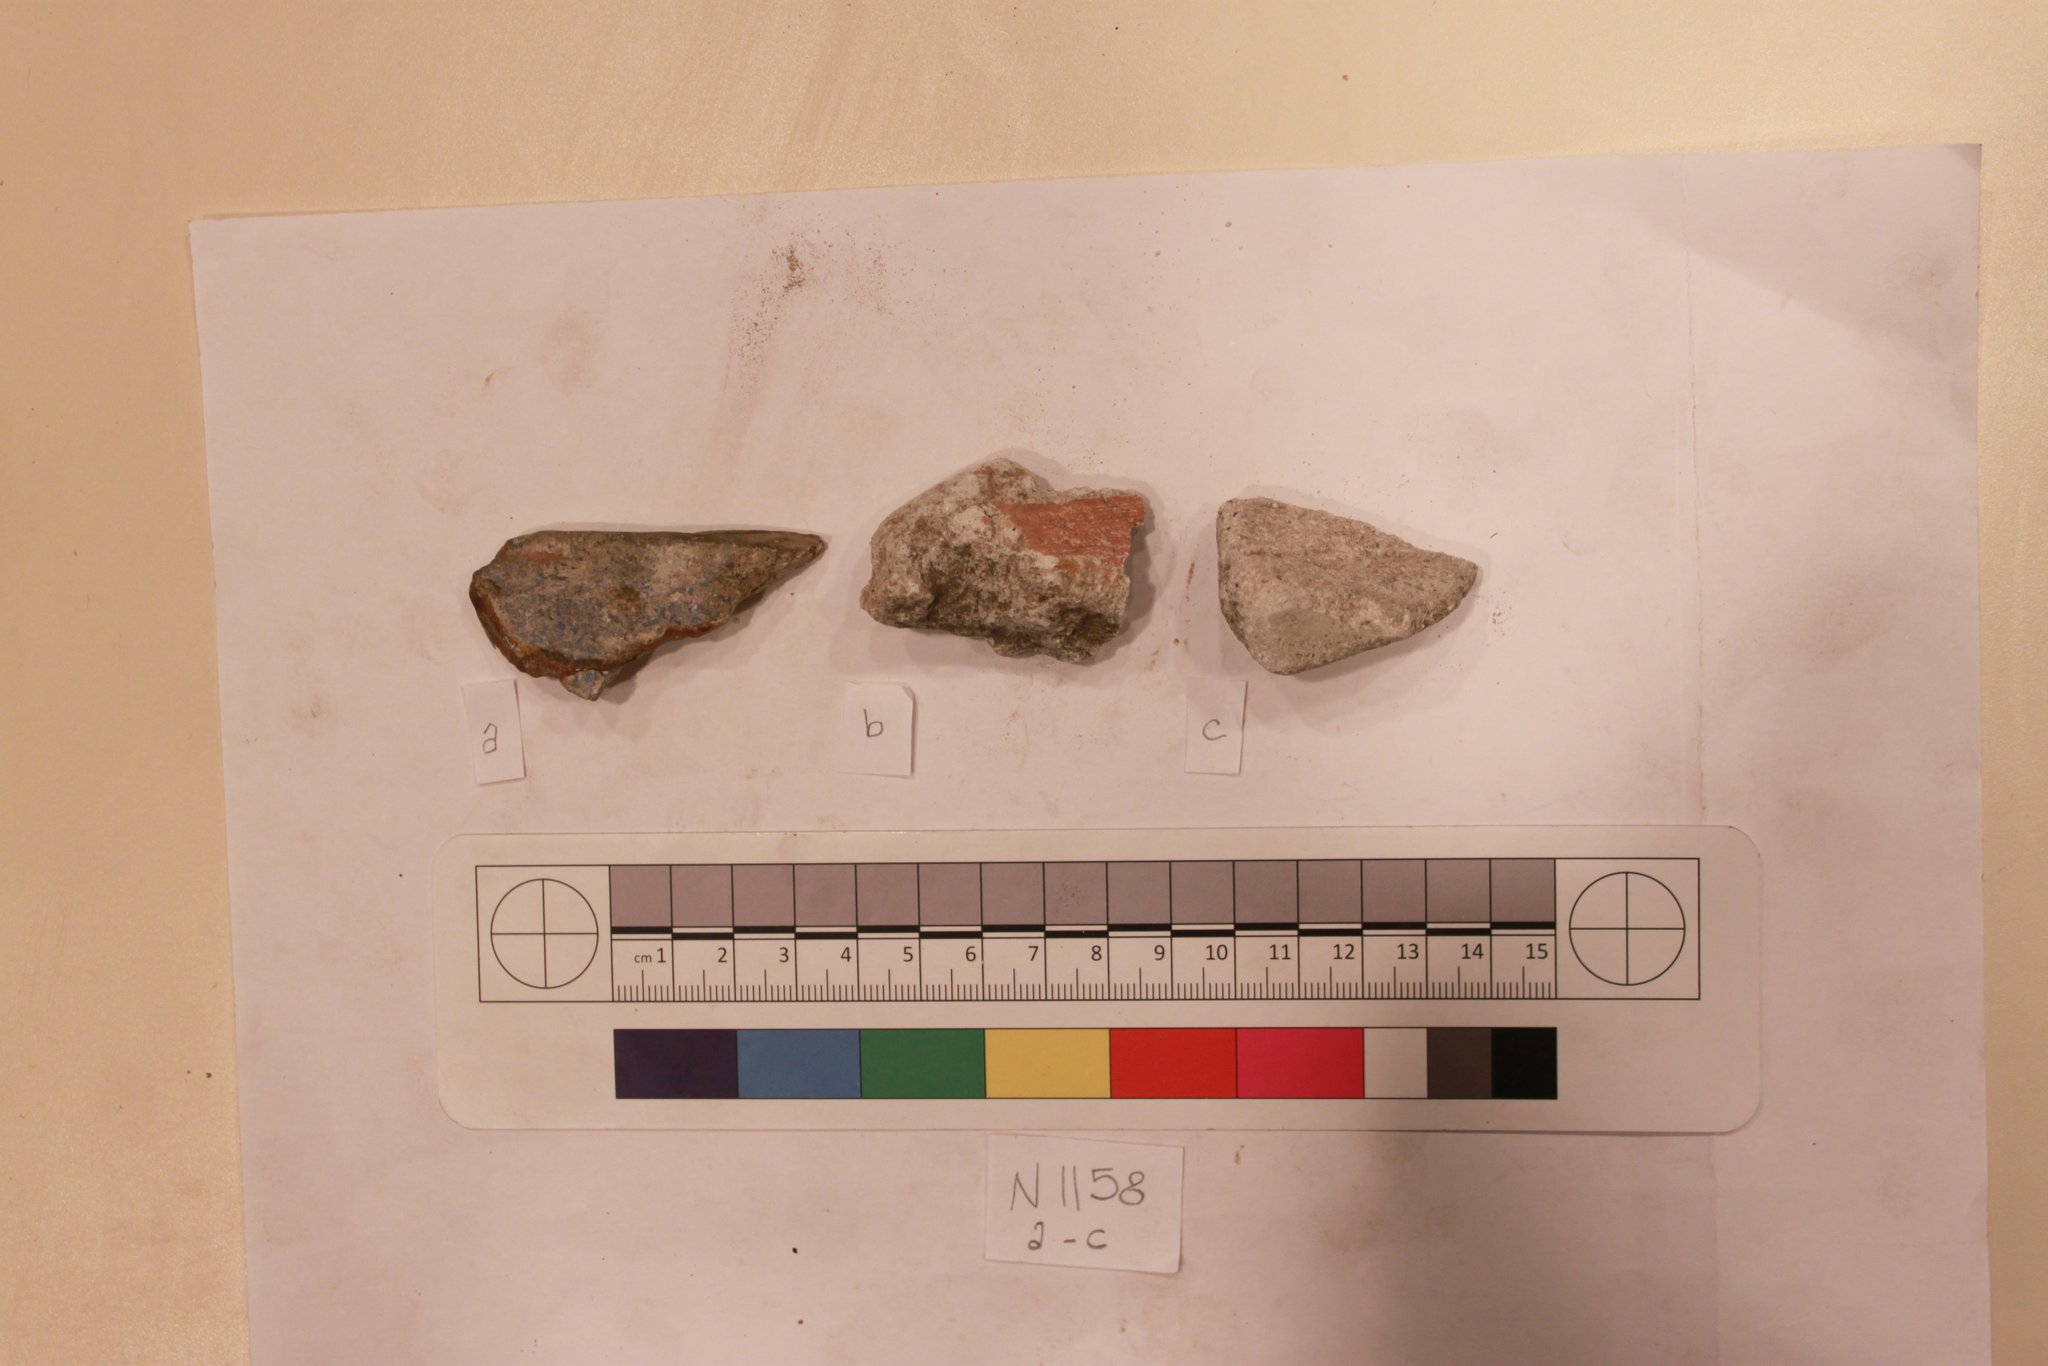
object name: fragment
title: Stucco Fragment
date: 701-1200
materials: plaster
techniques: carving, painting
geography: iran